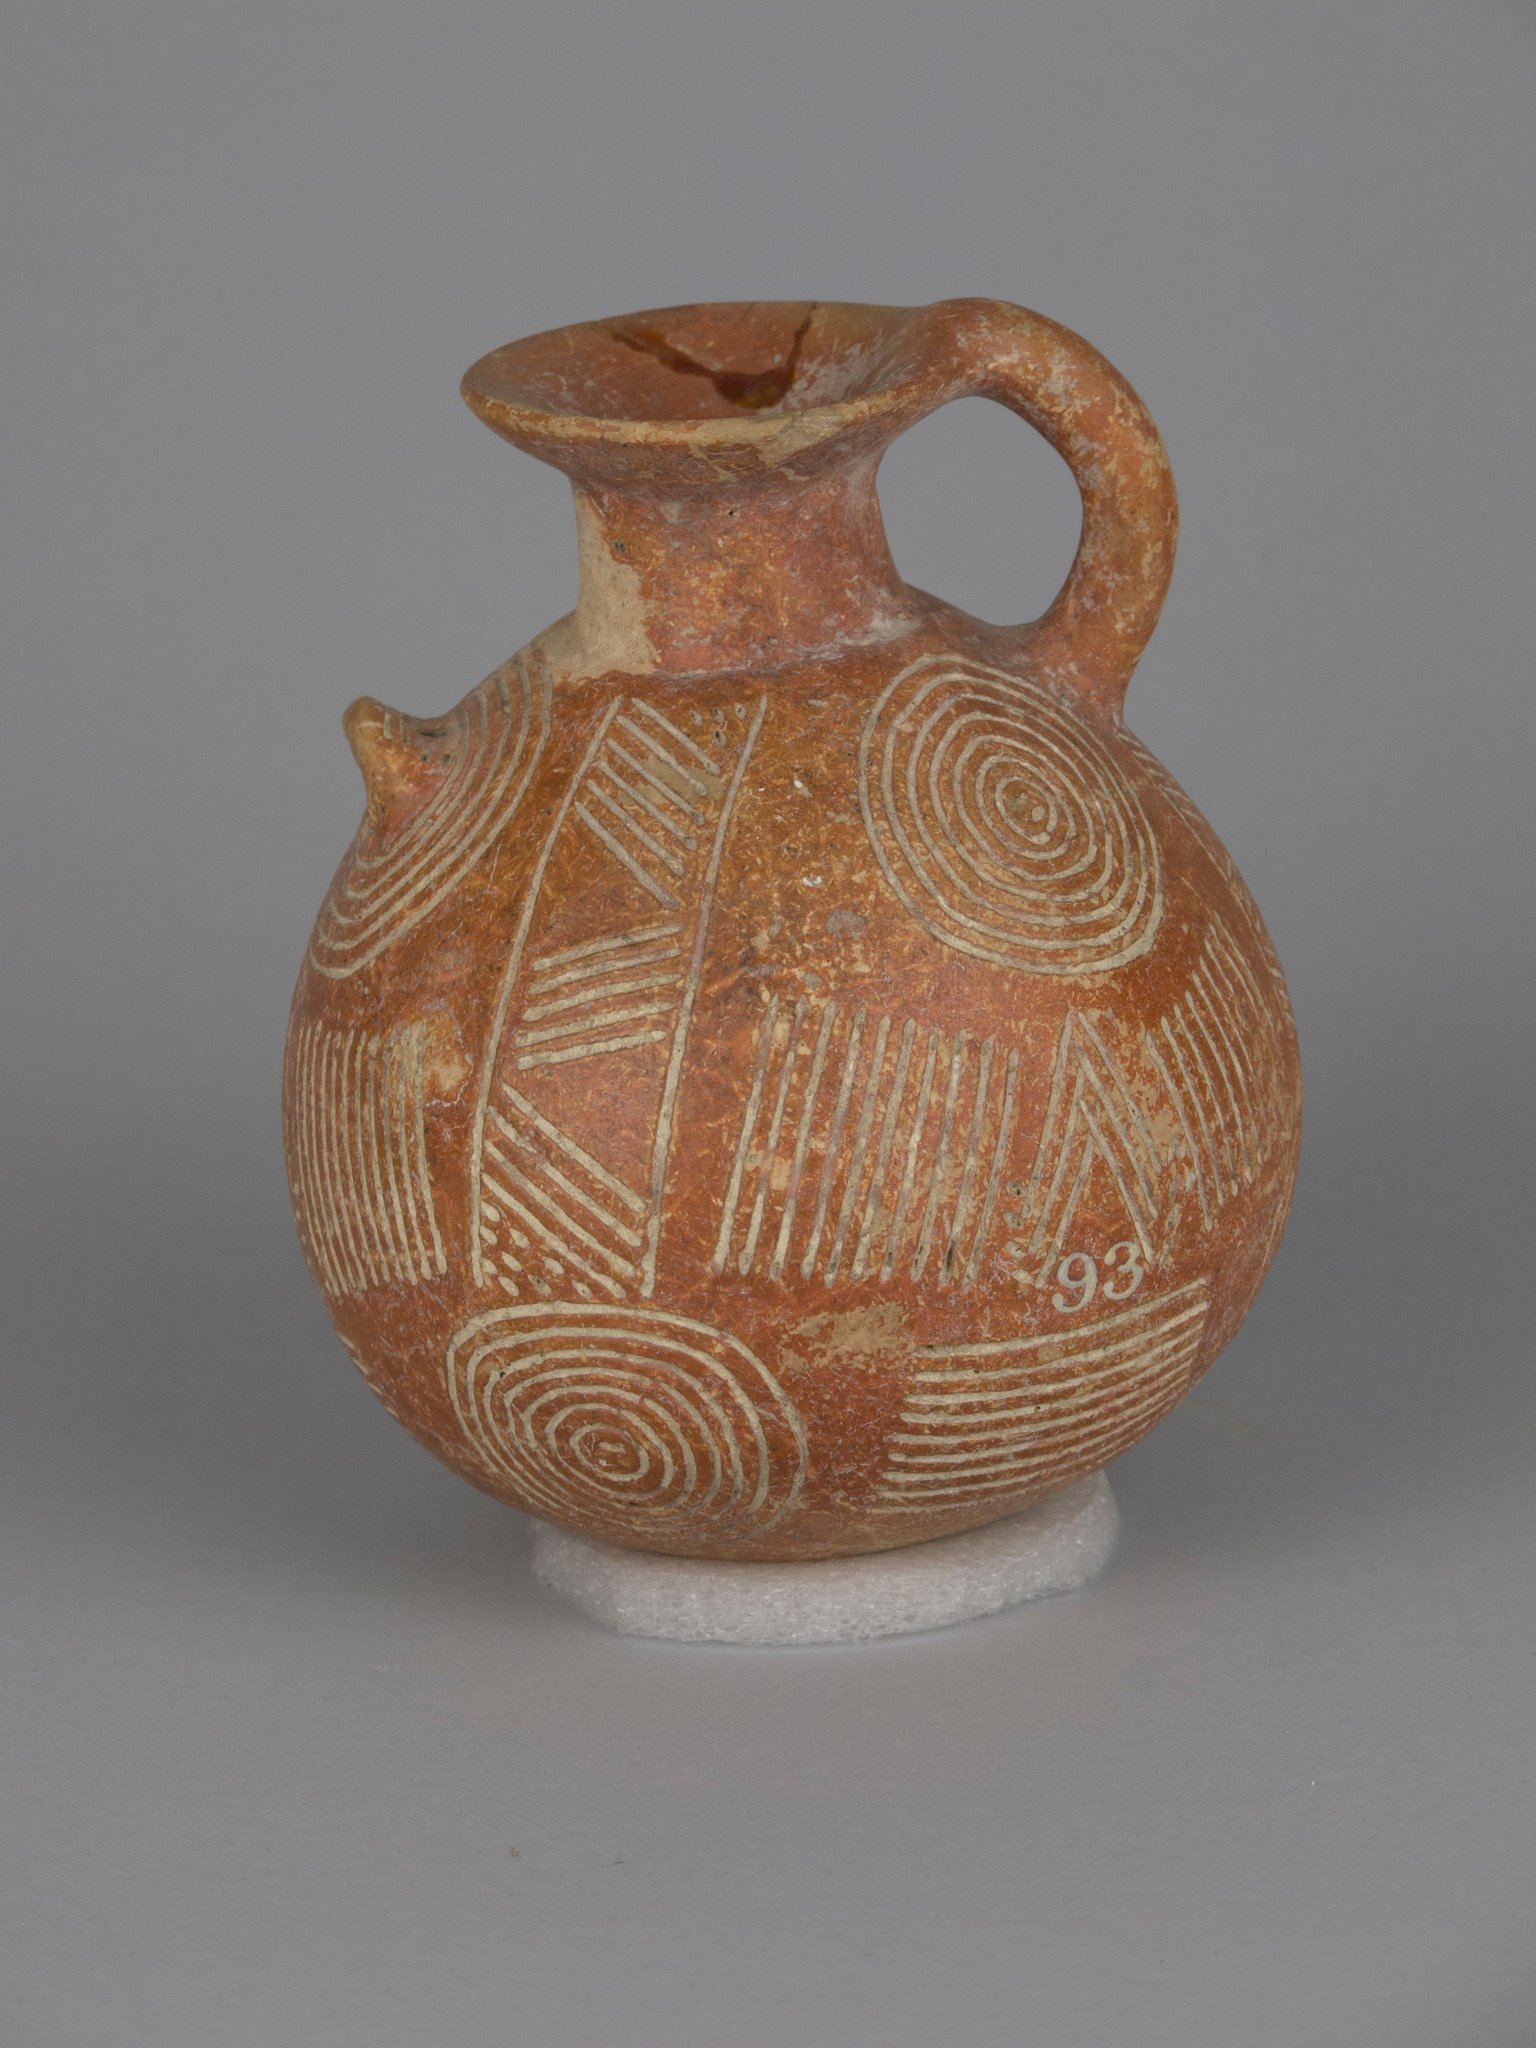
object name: juglet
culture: cypriot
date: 2500-1900 BCE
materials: terracotta